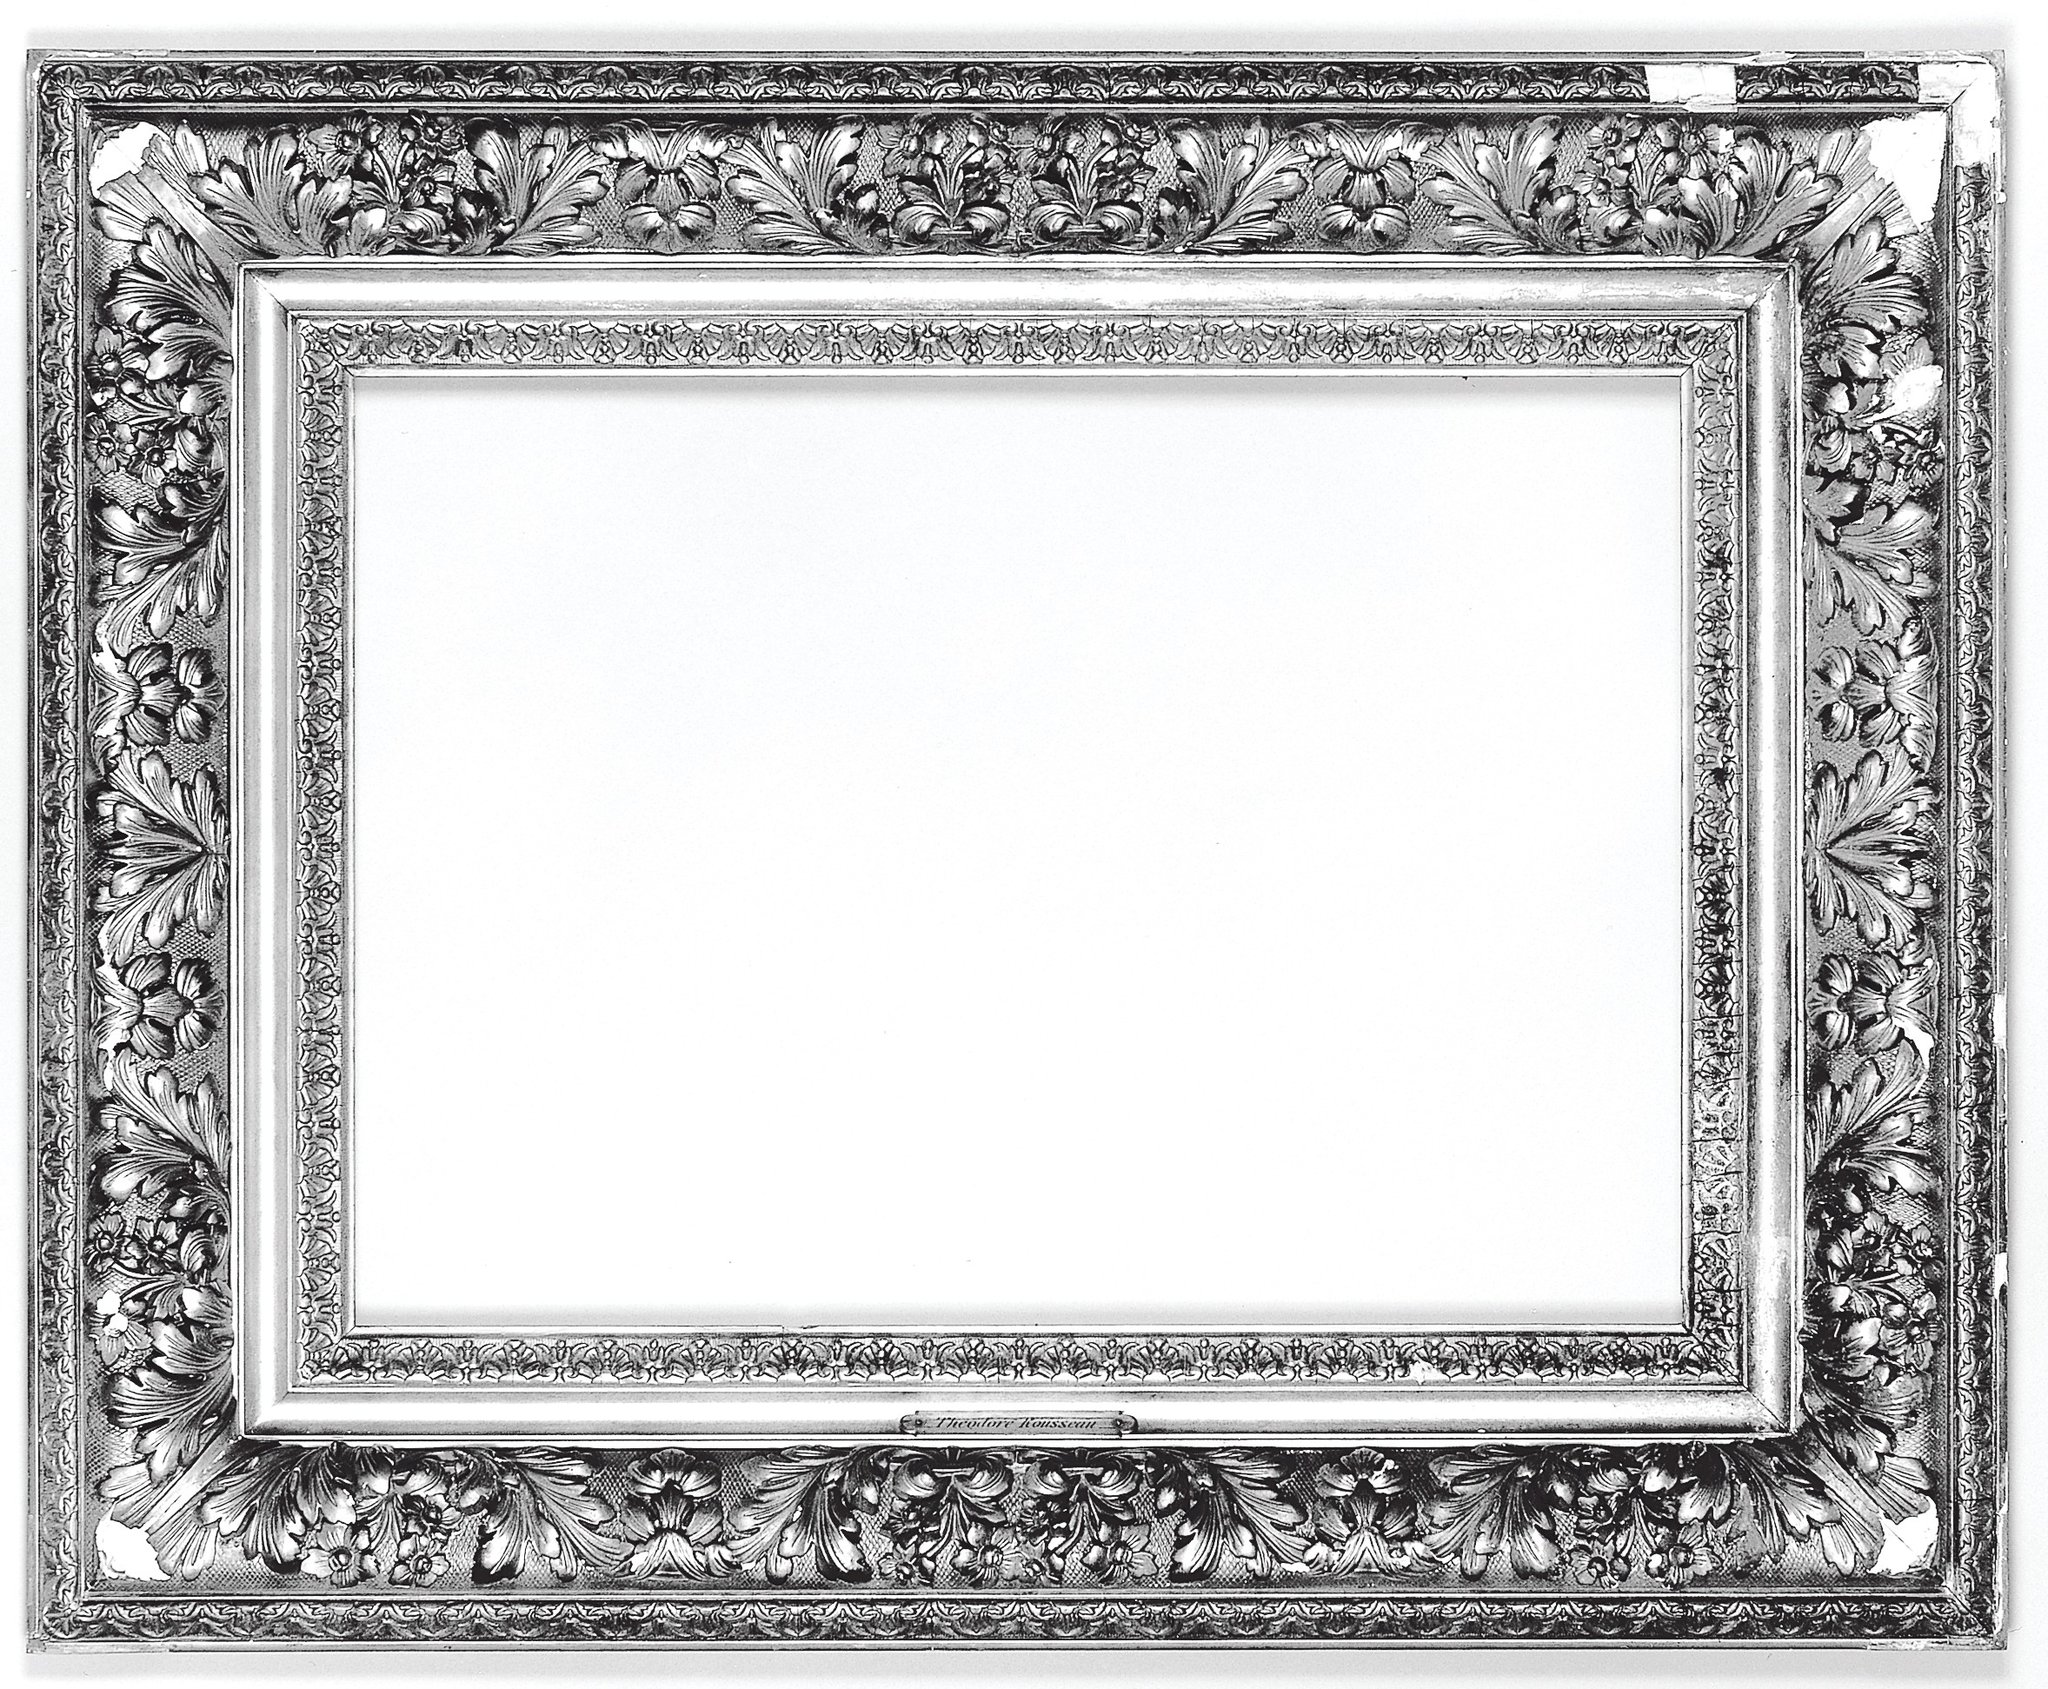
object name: frame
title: Barbizon frame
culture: french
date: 1850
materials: wood, plaster